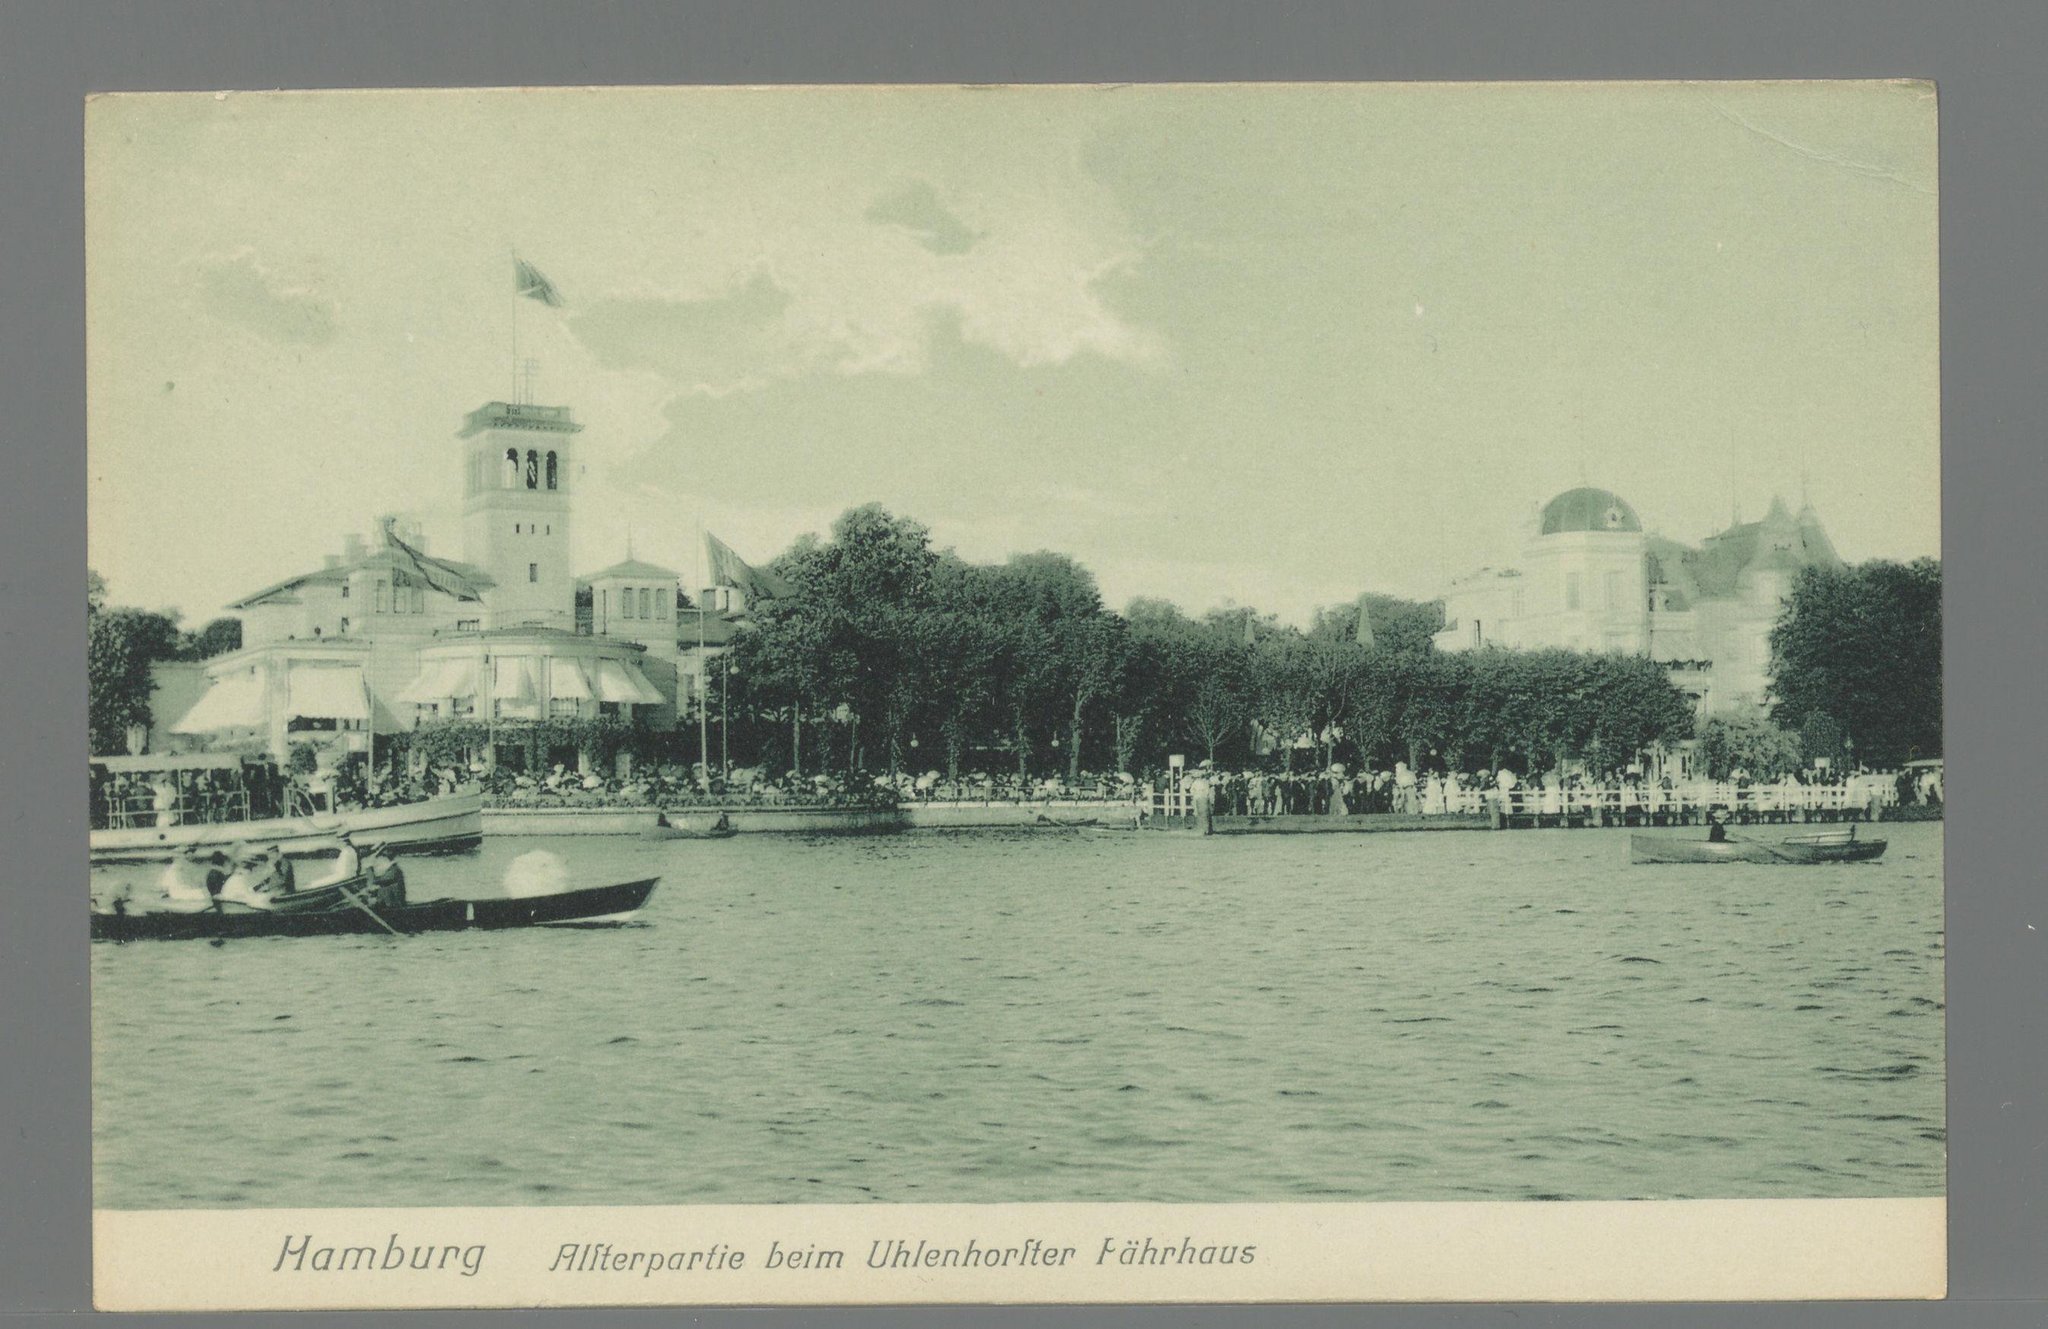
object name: photomechanical print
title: Luxusdruck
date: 1905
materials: cardboard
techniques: photograph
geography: hamburg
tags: rowing-boat, canoe, etc., canals, waters (in city)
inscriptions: date